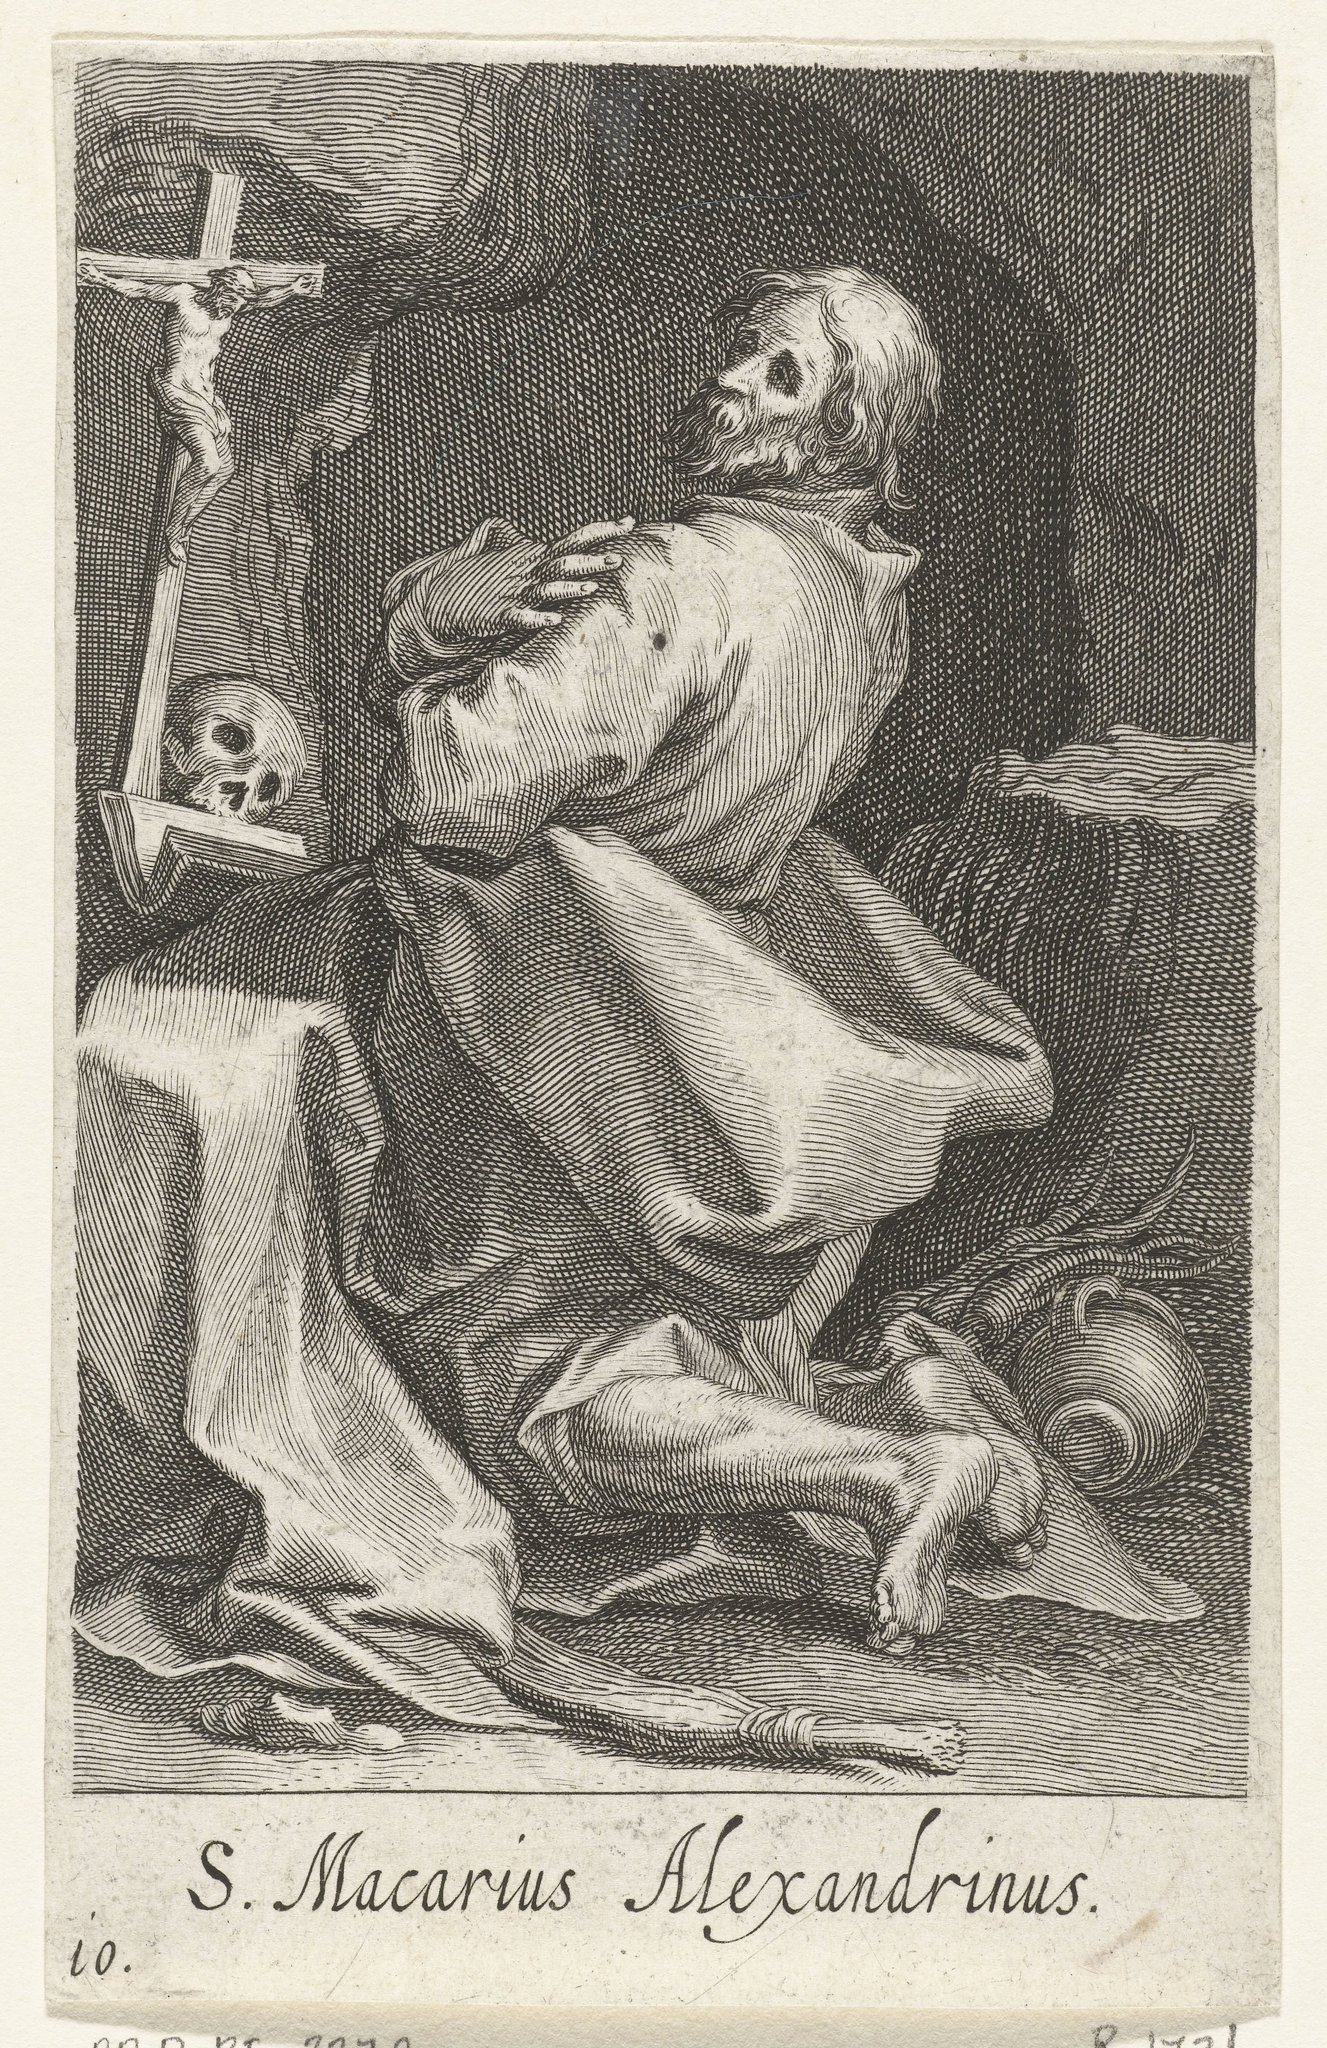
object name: book illustration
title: S. Macarius Alexandrinus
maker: boëtius adamsz. bolswert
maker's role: print maker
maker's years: 1580-1633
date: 1590-1612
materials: paper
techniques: engraving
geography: low countries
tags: saints, anchorite, hermit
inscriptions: collector's mark: Lugt 240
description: Prent uit: Sacra eremus ascetarum, geen plaats, Boëtius Adamsz. Bolswert, 1619. Eerste gebonden uitgave met in totaal vijftig prenten. Prent uit serie van vijfentwintig mannelijke kluizenaars. In 1612 verscheen een ongebonden editie maar op basis van de gewijzigde opschriften en samenstelling wordt aangenomen dat de prenten van de uitgave 1619 ook in 1612 of iets daarvoor gedrukt werden. Roethlisberger beschouwt de uitgave van 1619 als de eerste staat en de ongebonden editie van 1612 als de tweede staat (Roethlisberger 1993, p. 171, 172). Bij de tweede staat werd de naam van de heilige gewijzigd in de heilige Jacobus van Nisibis.